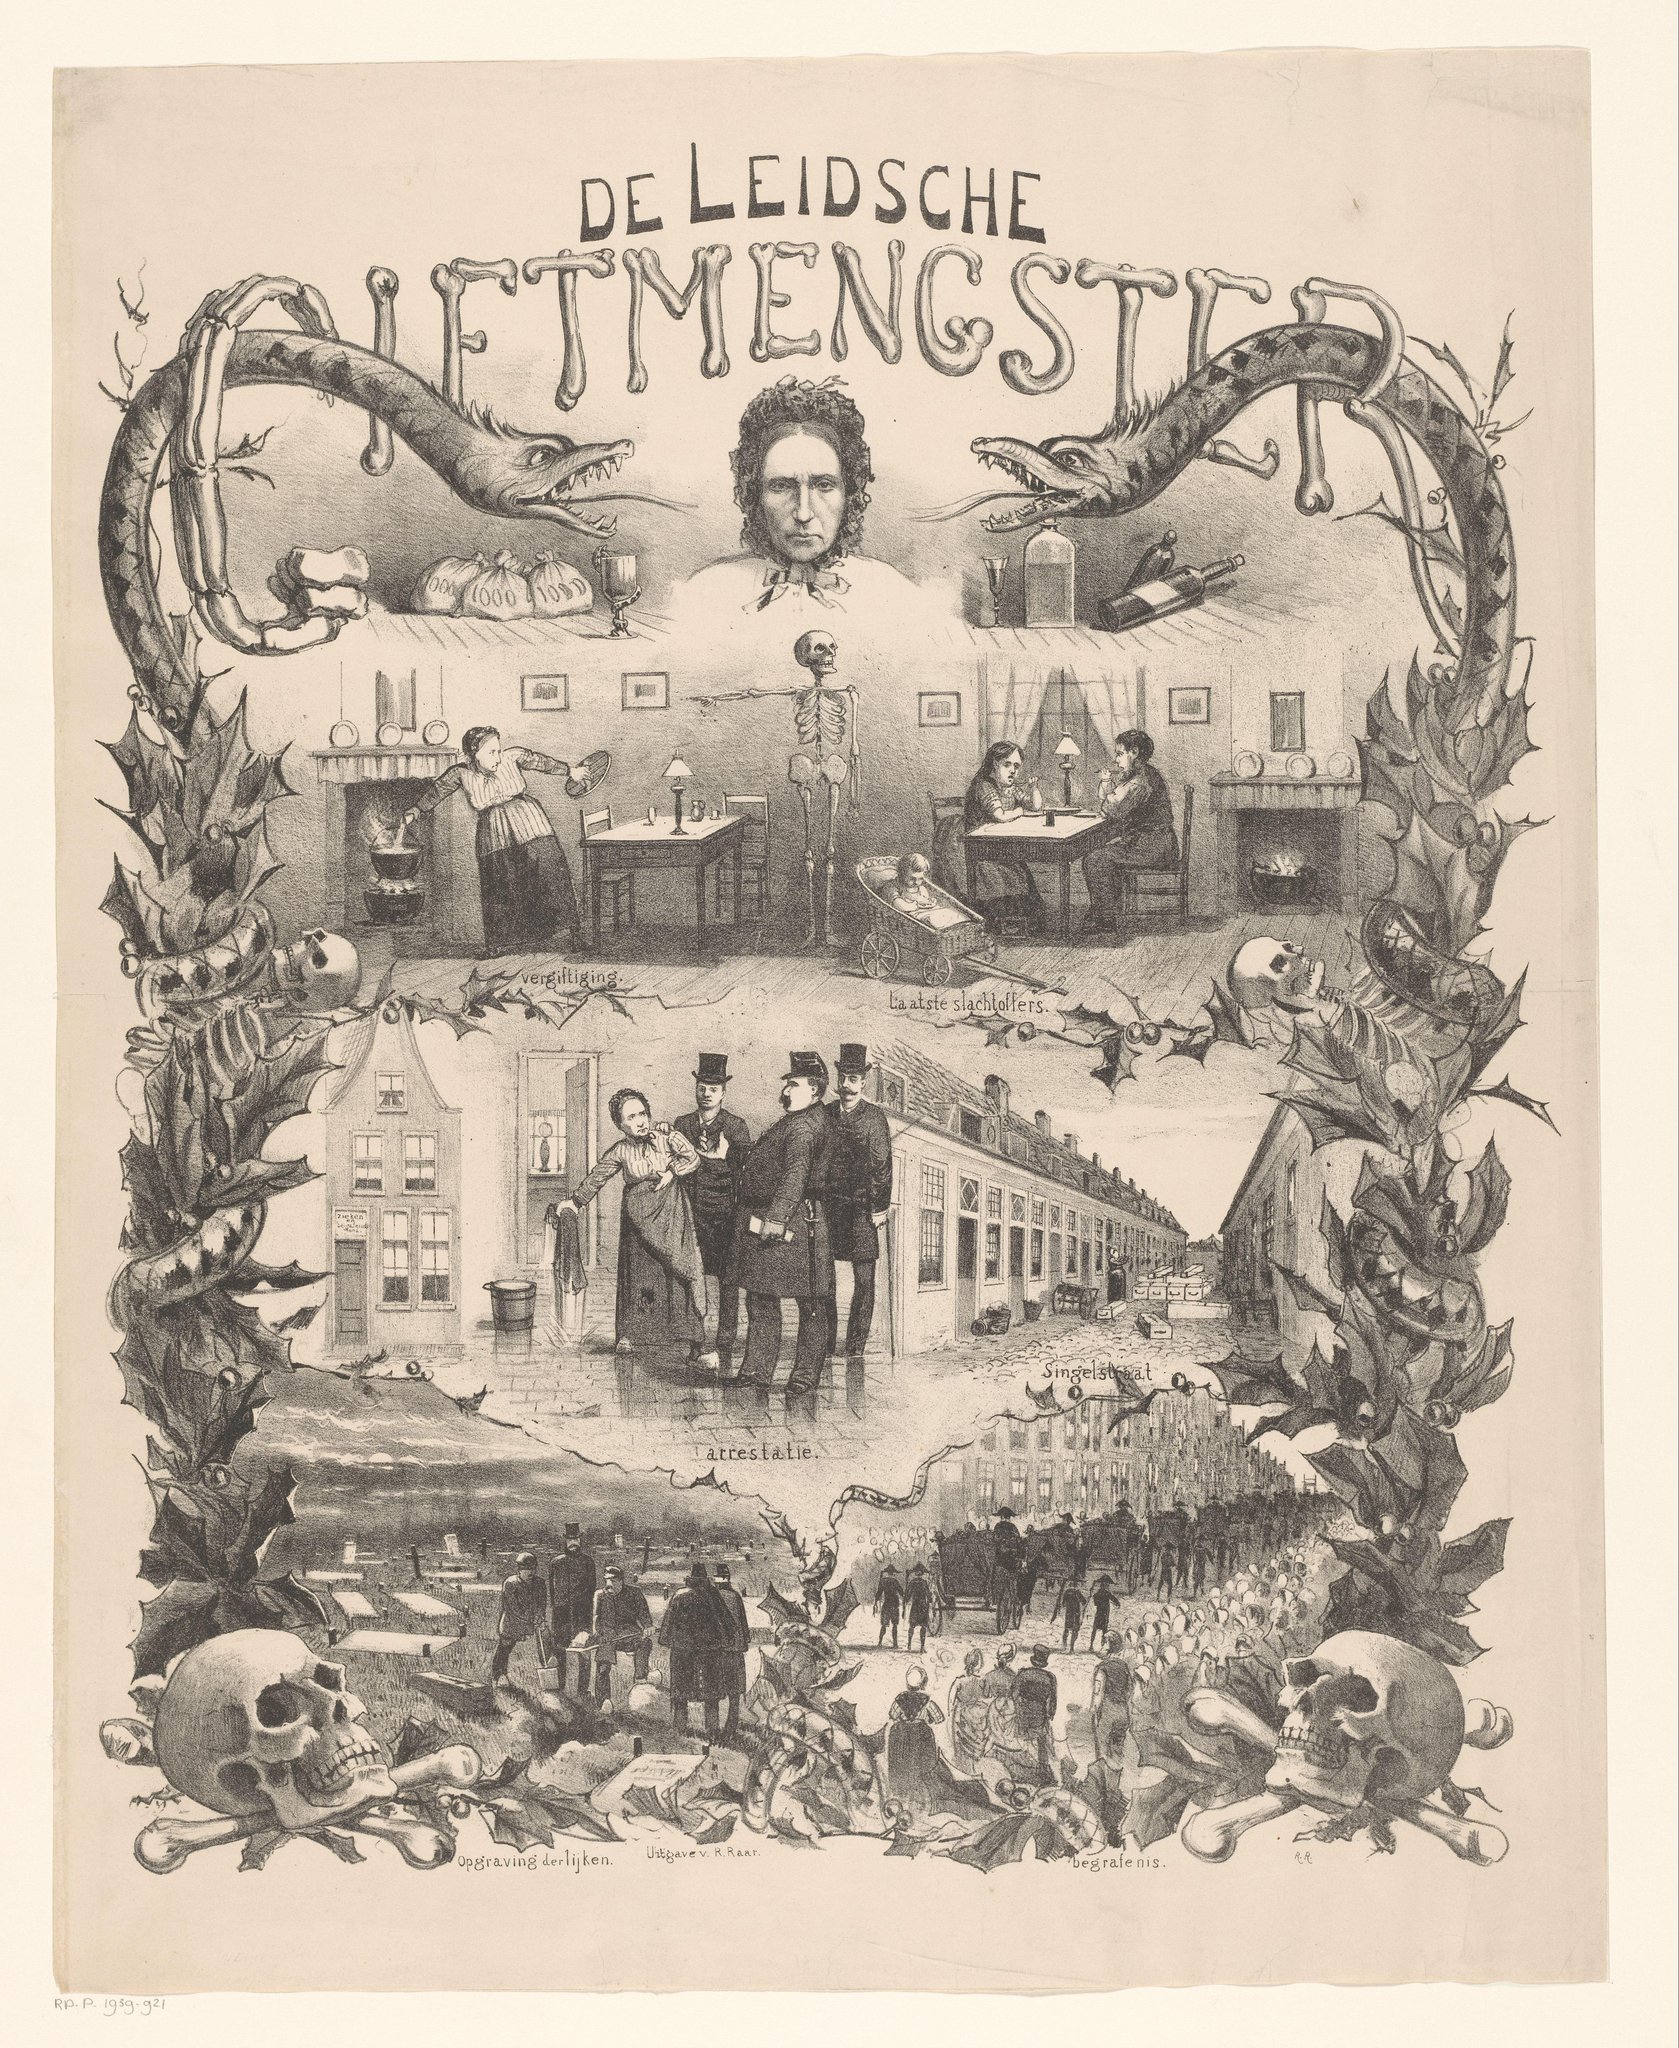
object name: print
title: Leven van seriemoordenares Maria Swanenburg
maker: roelof raar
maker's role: print maker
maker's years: 1855-1906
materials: paper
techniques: lithograph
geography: leiden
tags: leiden, historical persons - bb - woman, poisoner, arrest (of criminal), killing ~ aggressive relationships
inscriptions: collector's mark: Lugt 2760, collector's mark: Lugt 2228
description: Verhalende voorstelling van het leven van de Leidse gifmengster Maria Swanenburg, ook wel Goeie Mie genoemd. Aan de bovenzijde het portret van de seriemoordenares met een slang aan weerszijden. Daaronder staat zij in een pan te roeren waarin vergif zit en zitten haar laatste slachtoffers van haar aan tafel. In het midden de arrestatie van Swanenburg. Aan de onderzijde de opgraving van graven en een begrafenisstoet. Op 1 mei 1885 werd de moordenares veroordeeld.